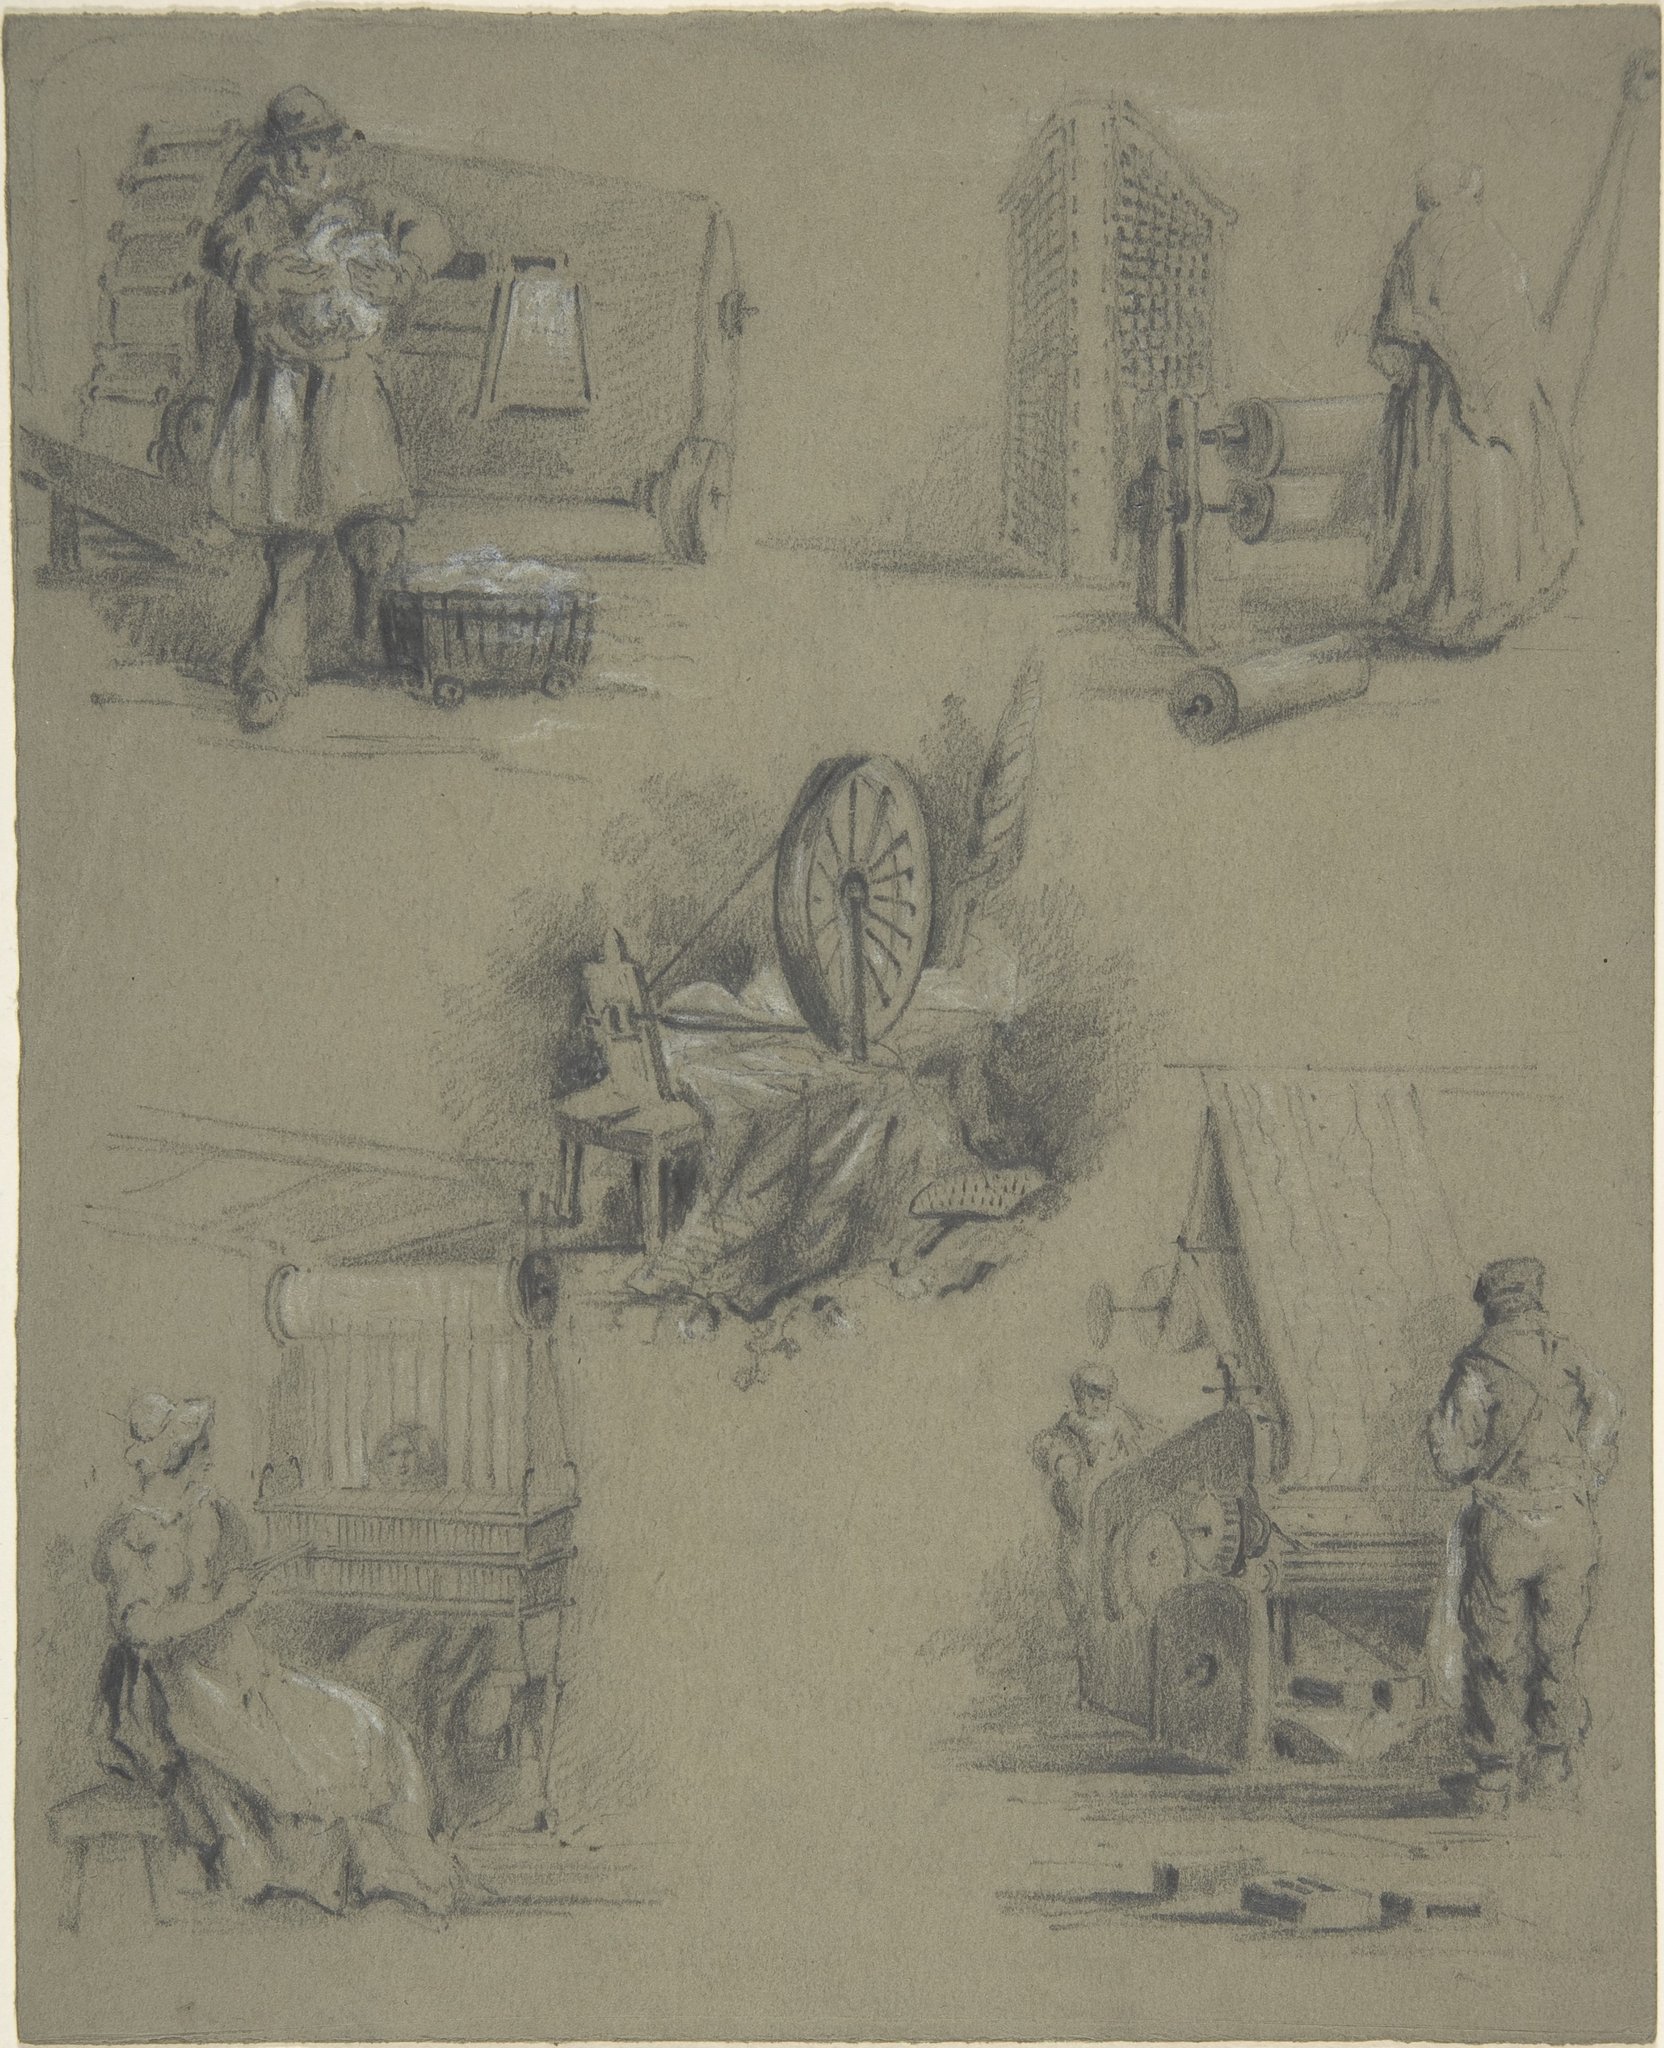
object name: drawing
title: Five drawings showing processes of weaving and spinning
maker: anonymous, british, 19th century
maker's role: artist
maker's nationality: british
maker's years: 1800-1900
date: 1801-1900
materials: chalk, graphite, paper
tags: human figures,working